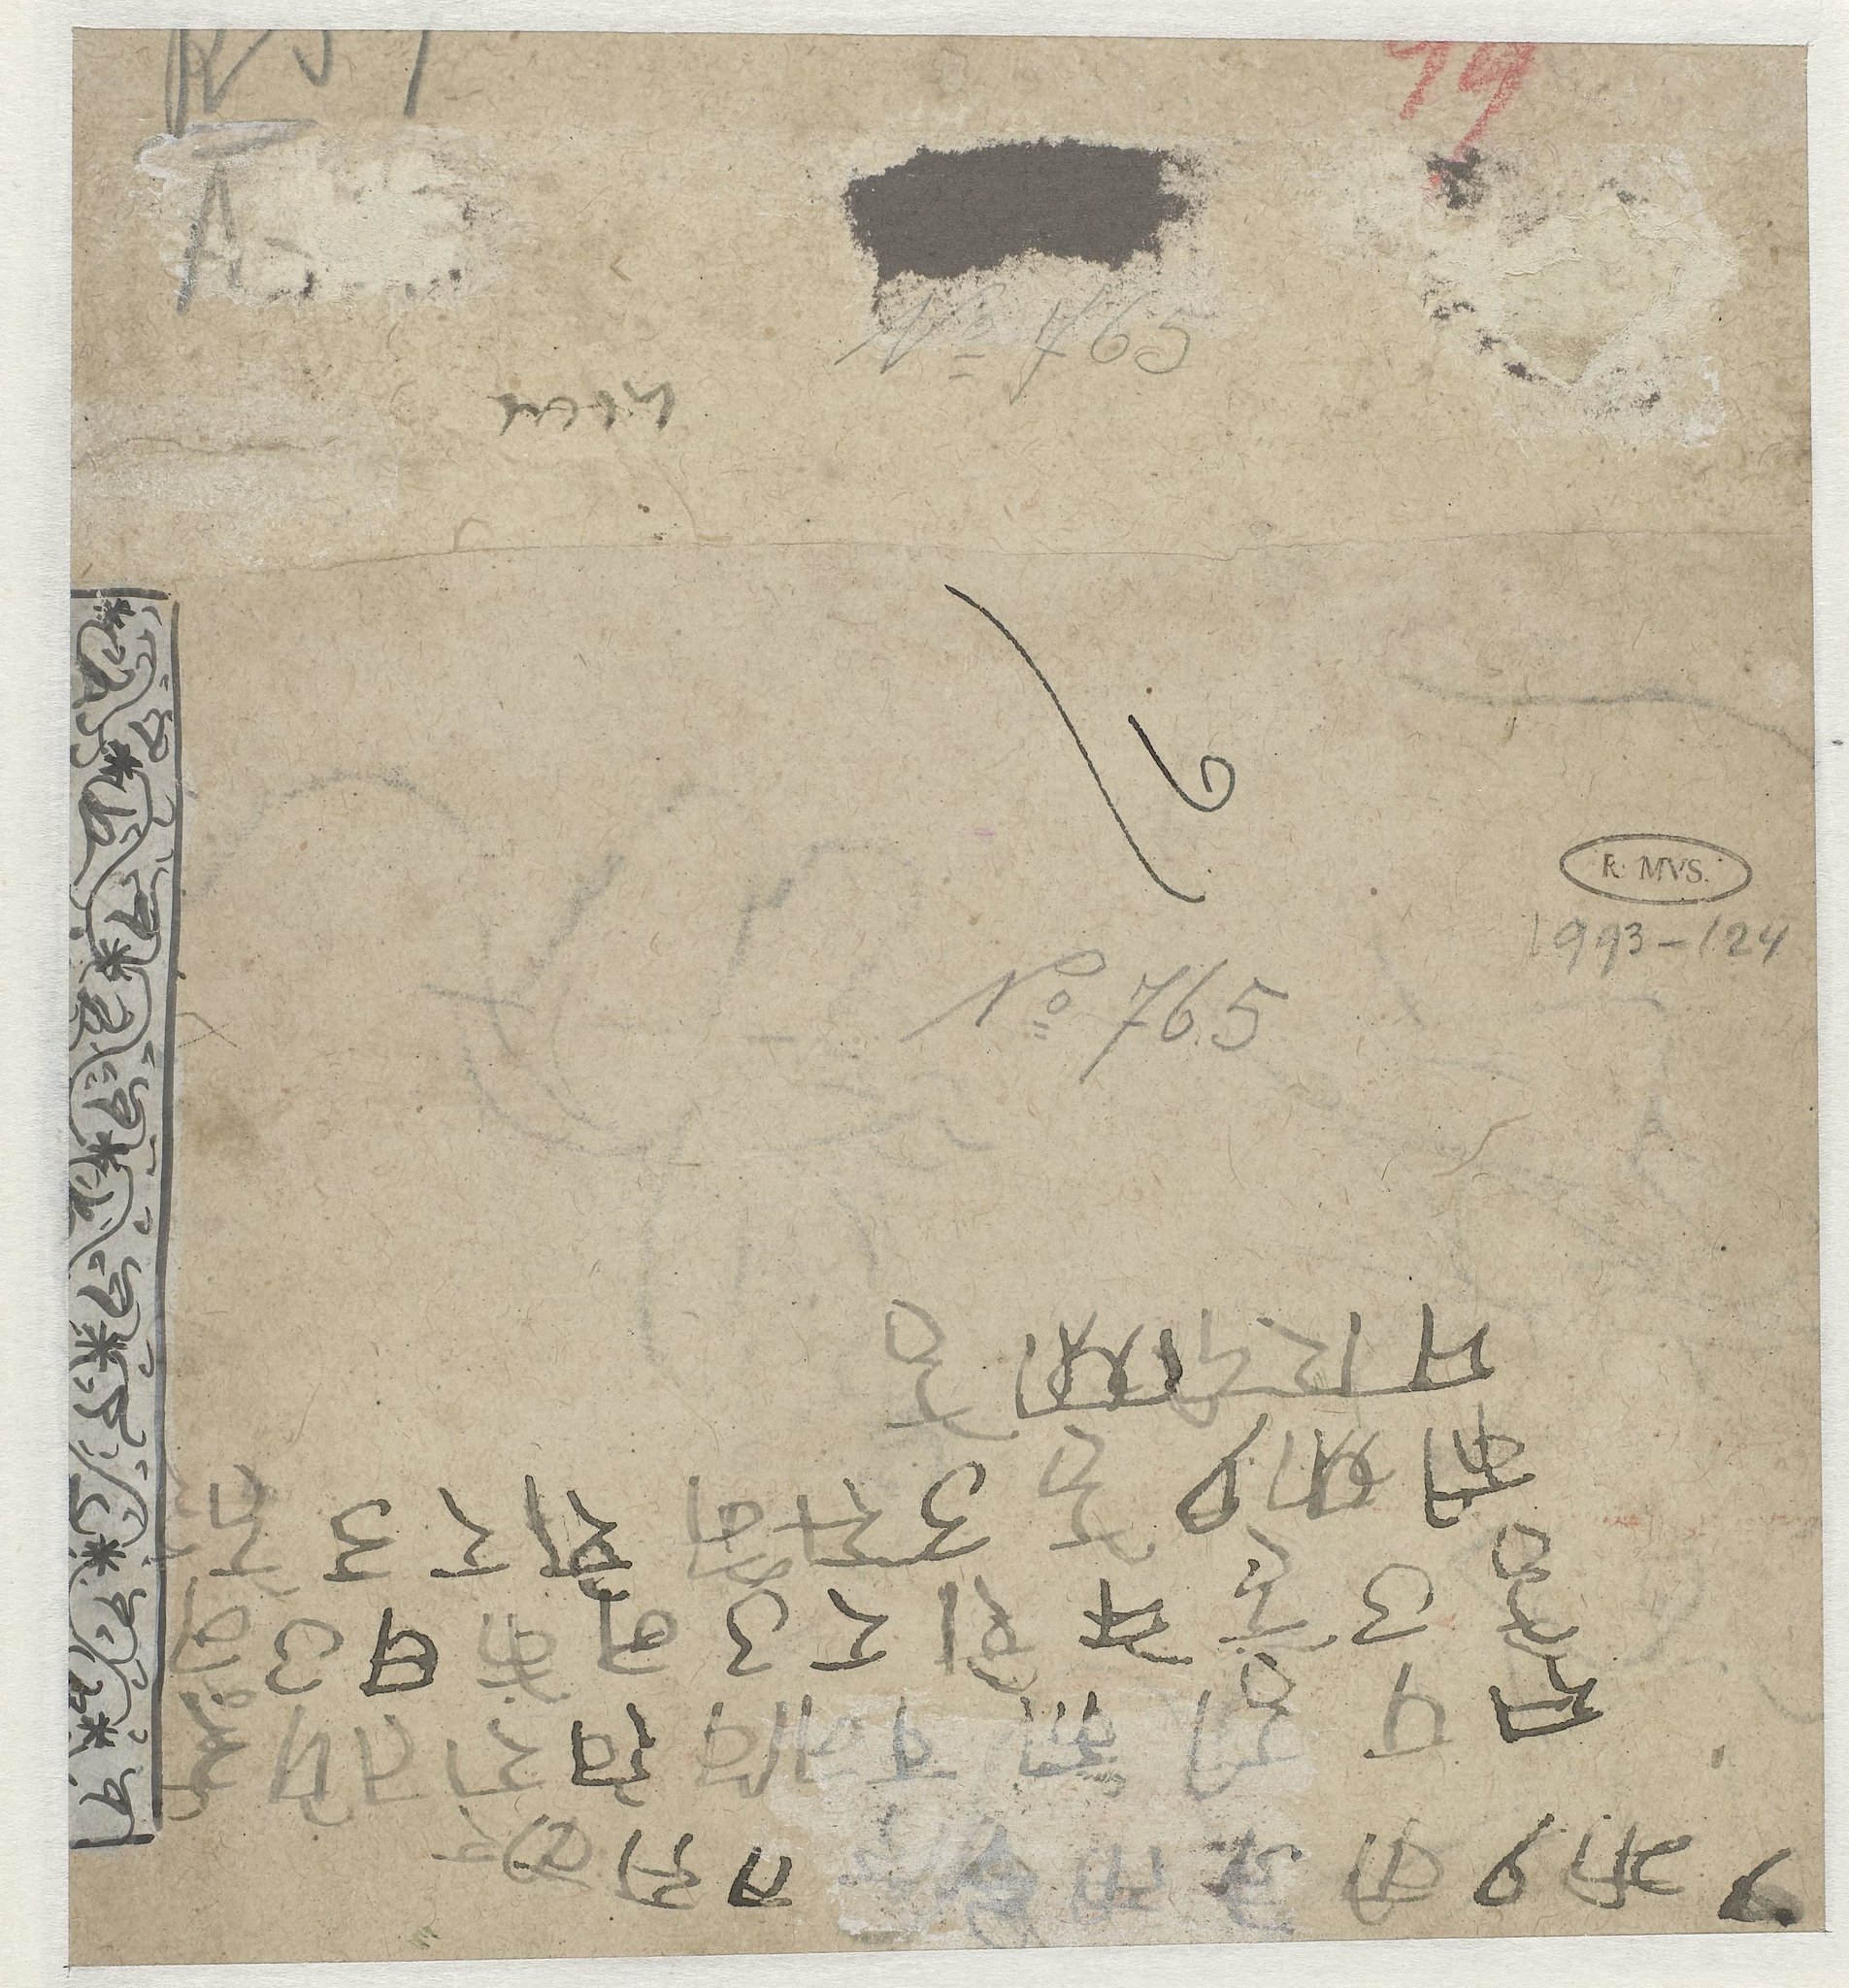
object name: ornamenttekening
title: Tekst en rand van ornament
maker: Anonymous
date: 1725-1735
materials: paper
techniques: brush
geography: basohli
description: Enkele regels in het Panjabi, waarin de situatie van de miniatuur wordt beschreven, zonder dat er uit blijkt van welk verhaal deze schildering een illustratie is.